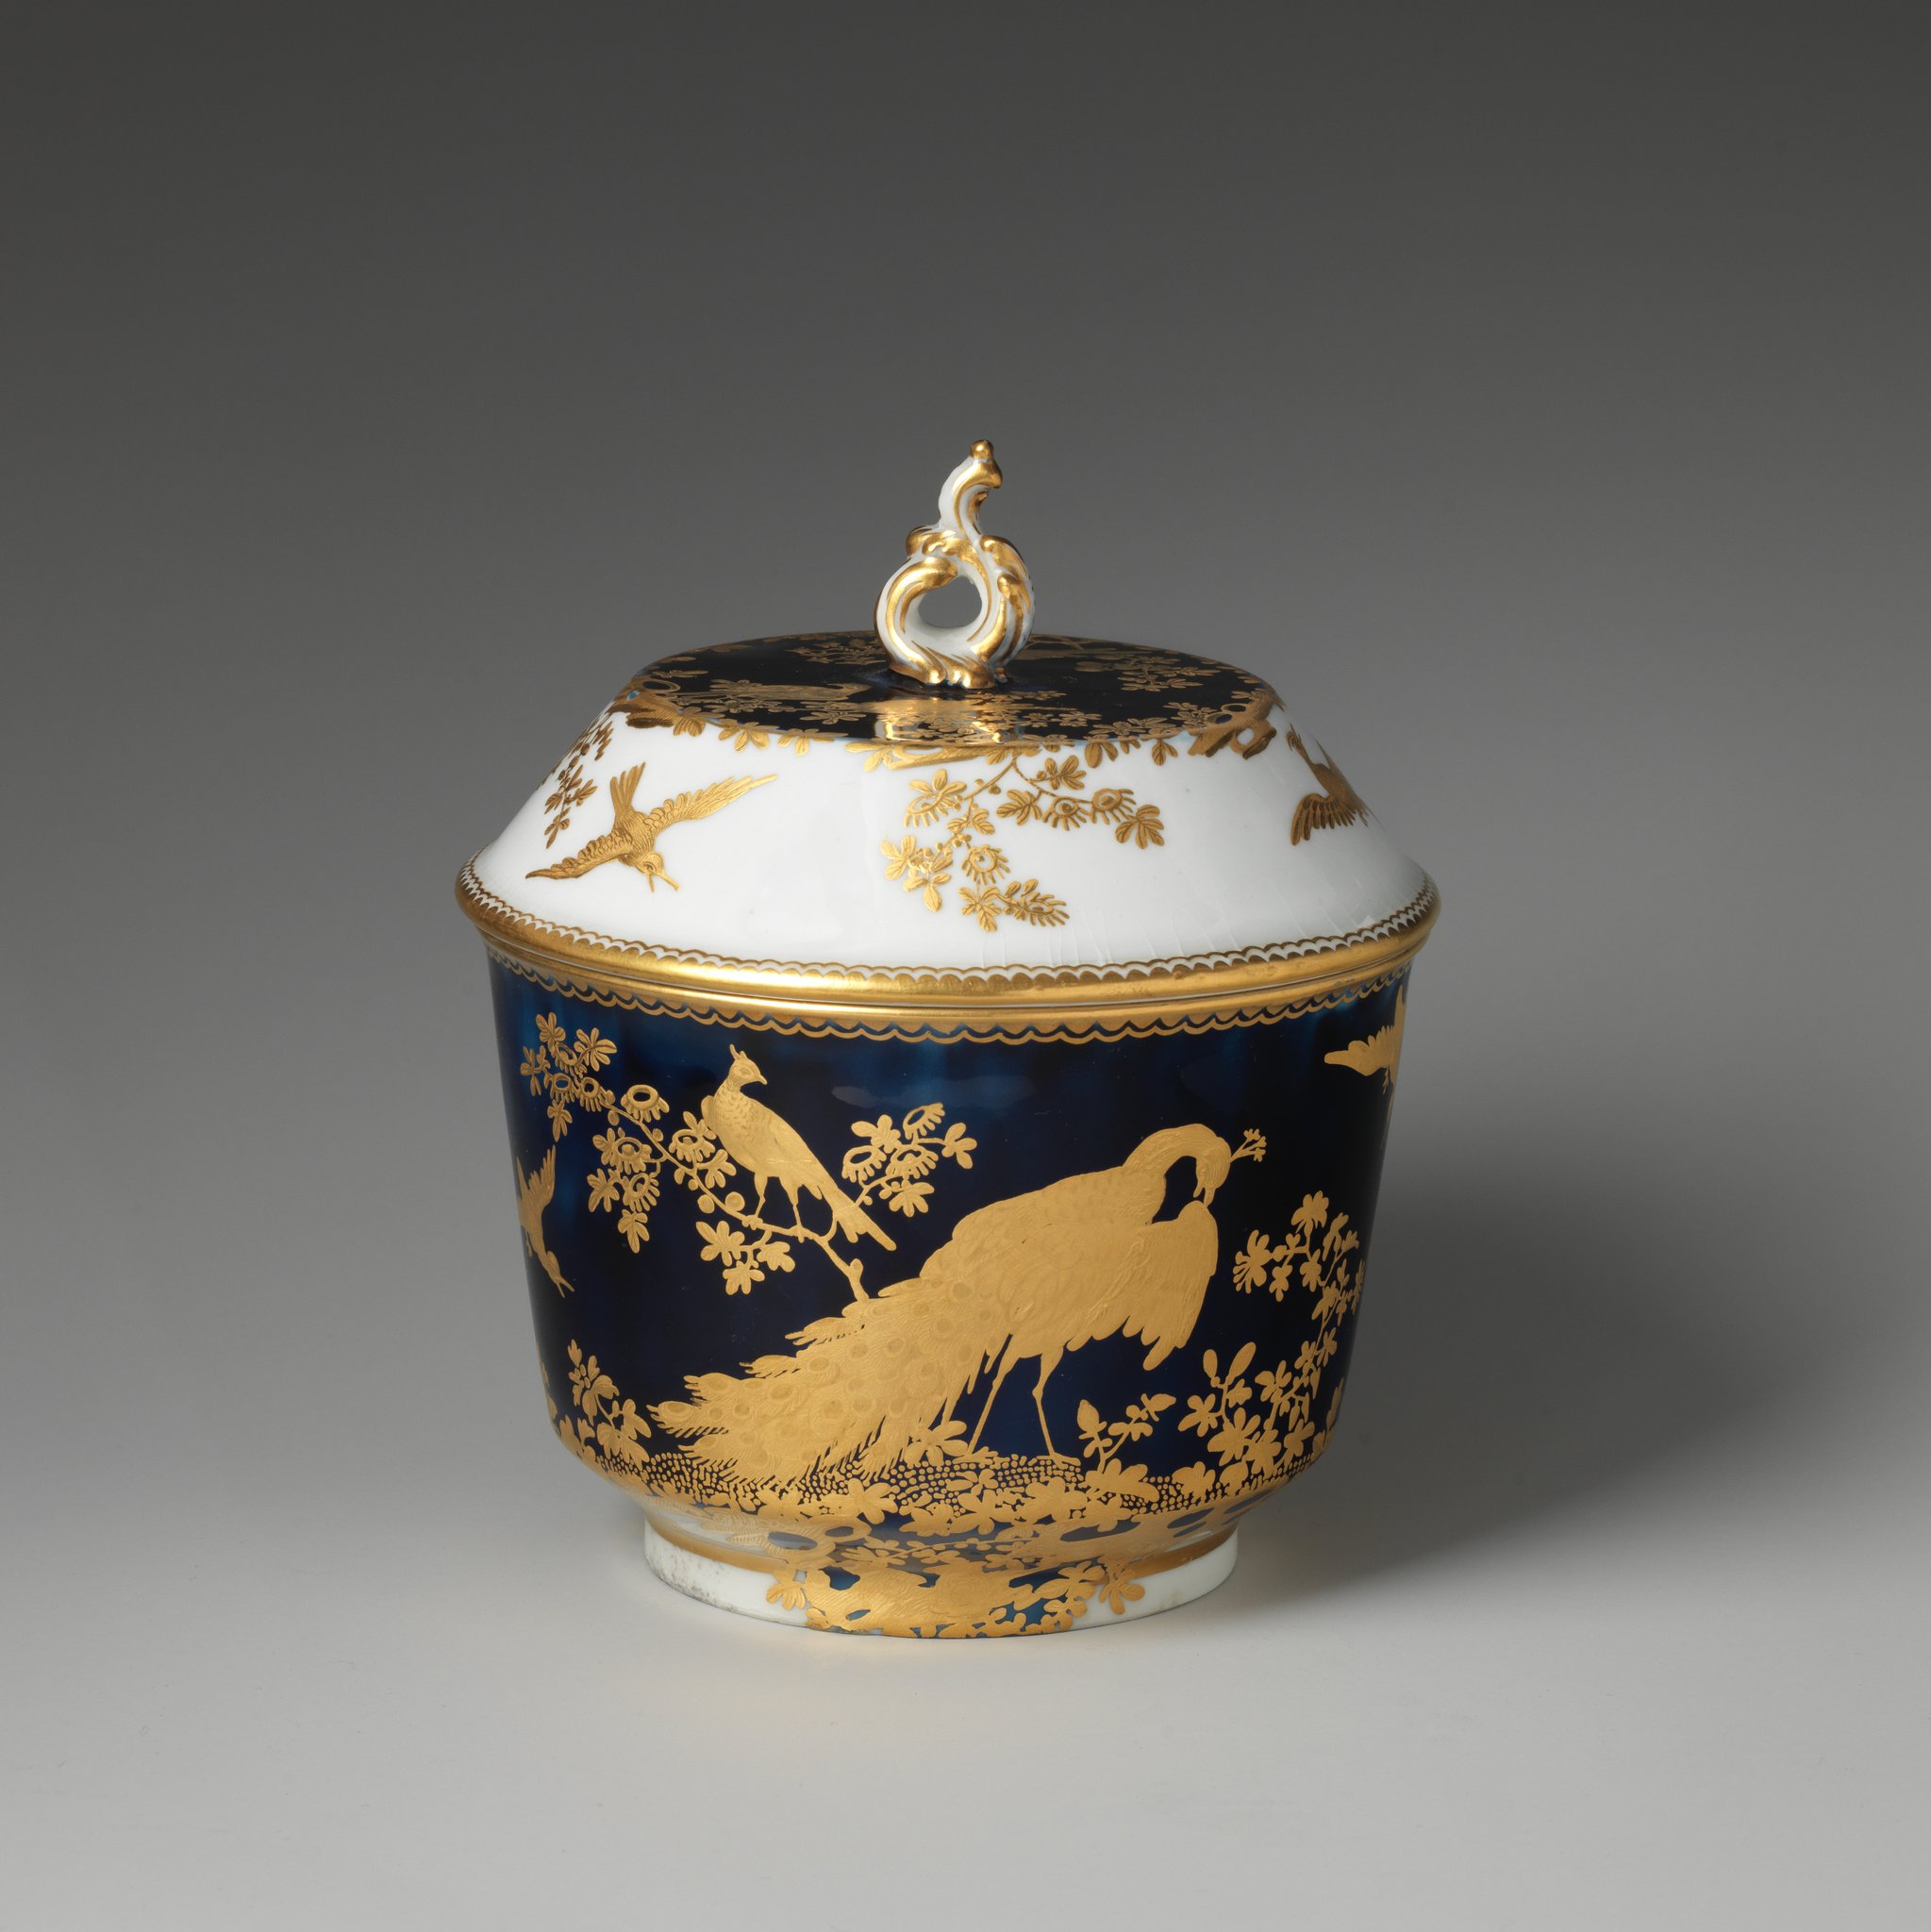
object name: sugar bowl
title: Sugar bowl (part of a service)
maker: chelsea porcelain manufactory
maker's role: factory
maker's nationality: british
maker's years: 1744-1784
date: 1758-1769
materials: enamel, soft paste porcelain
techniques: gilding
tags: peacocks,pheasants